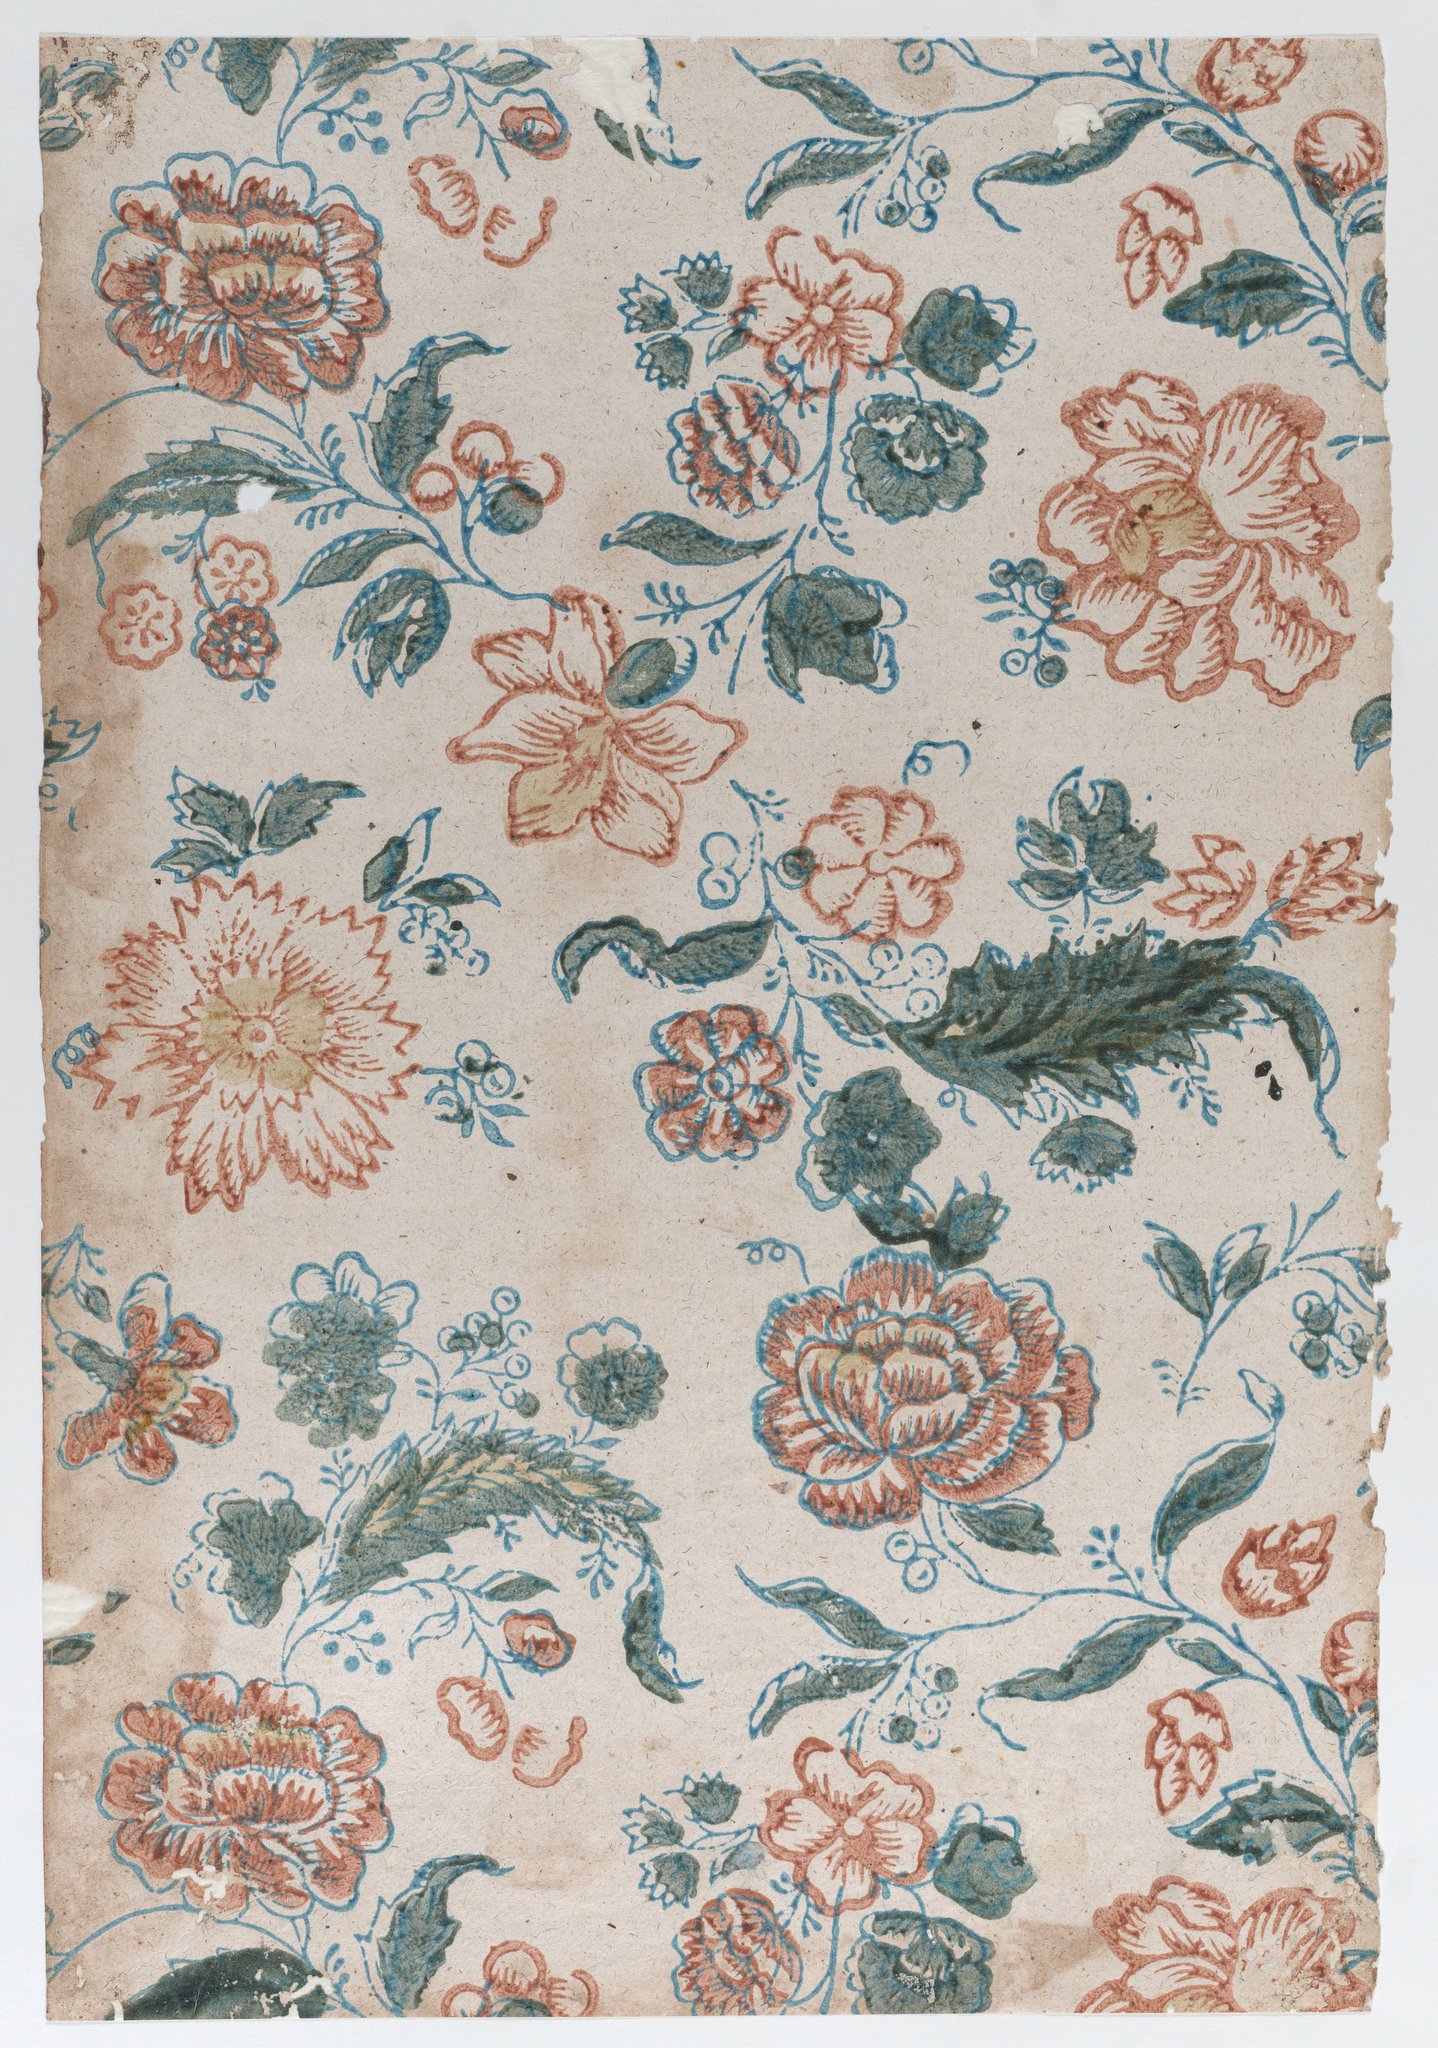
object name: print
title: Decorative paper with an overall floral pattern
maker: Anonymous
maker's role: artist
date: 1701-1800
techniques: relief print